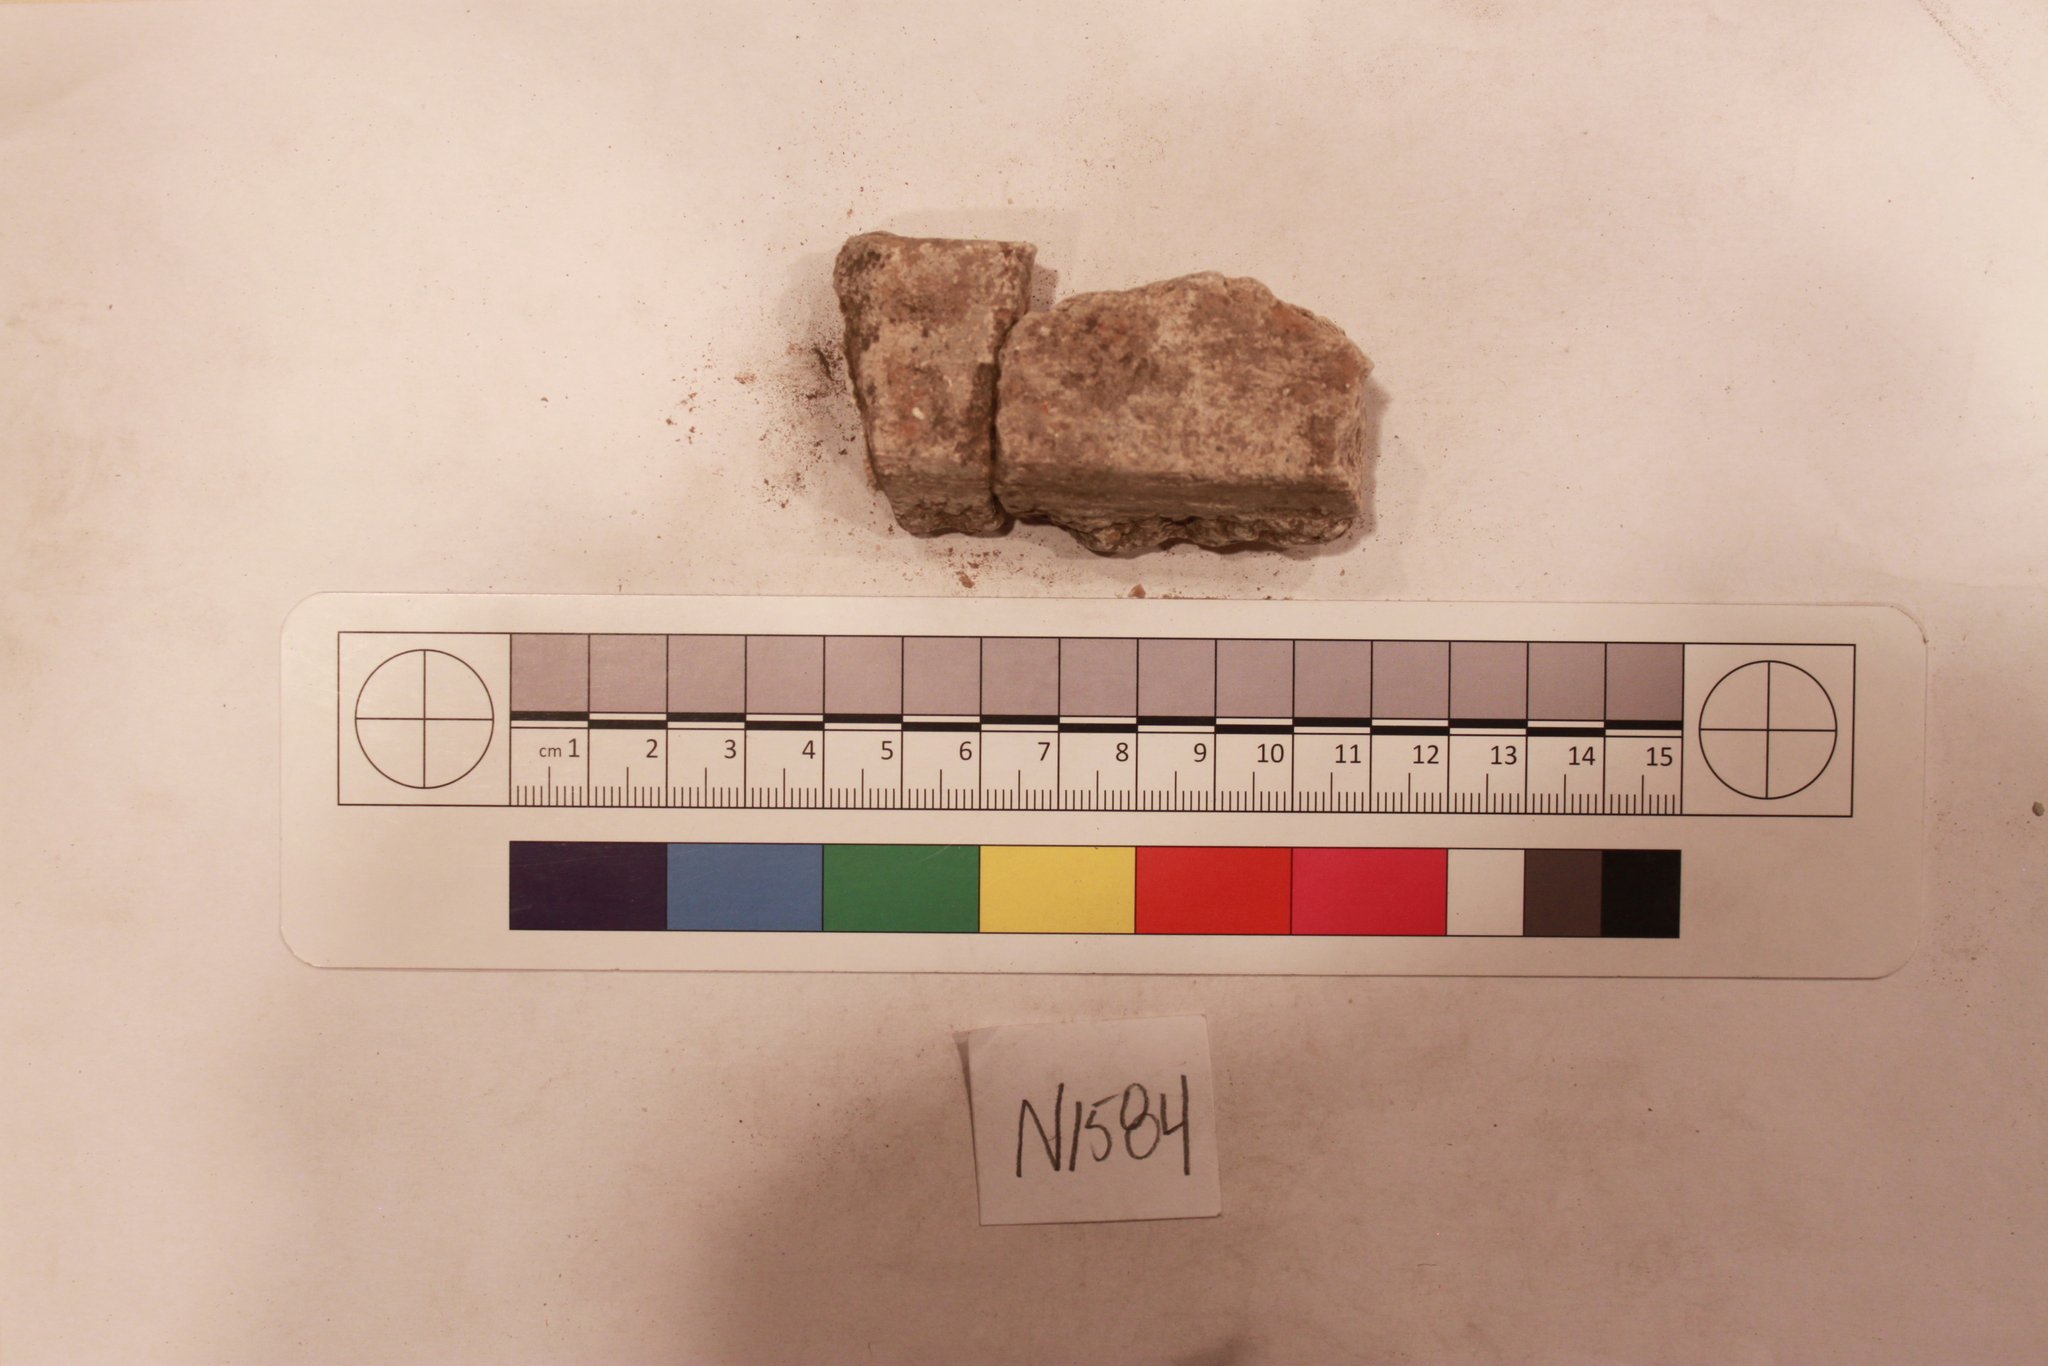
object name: fragment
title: Stucco Fragment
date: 701-1200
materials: plaster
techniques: carving, painting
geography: iran